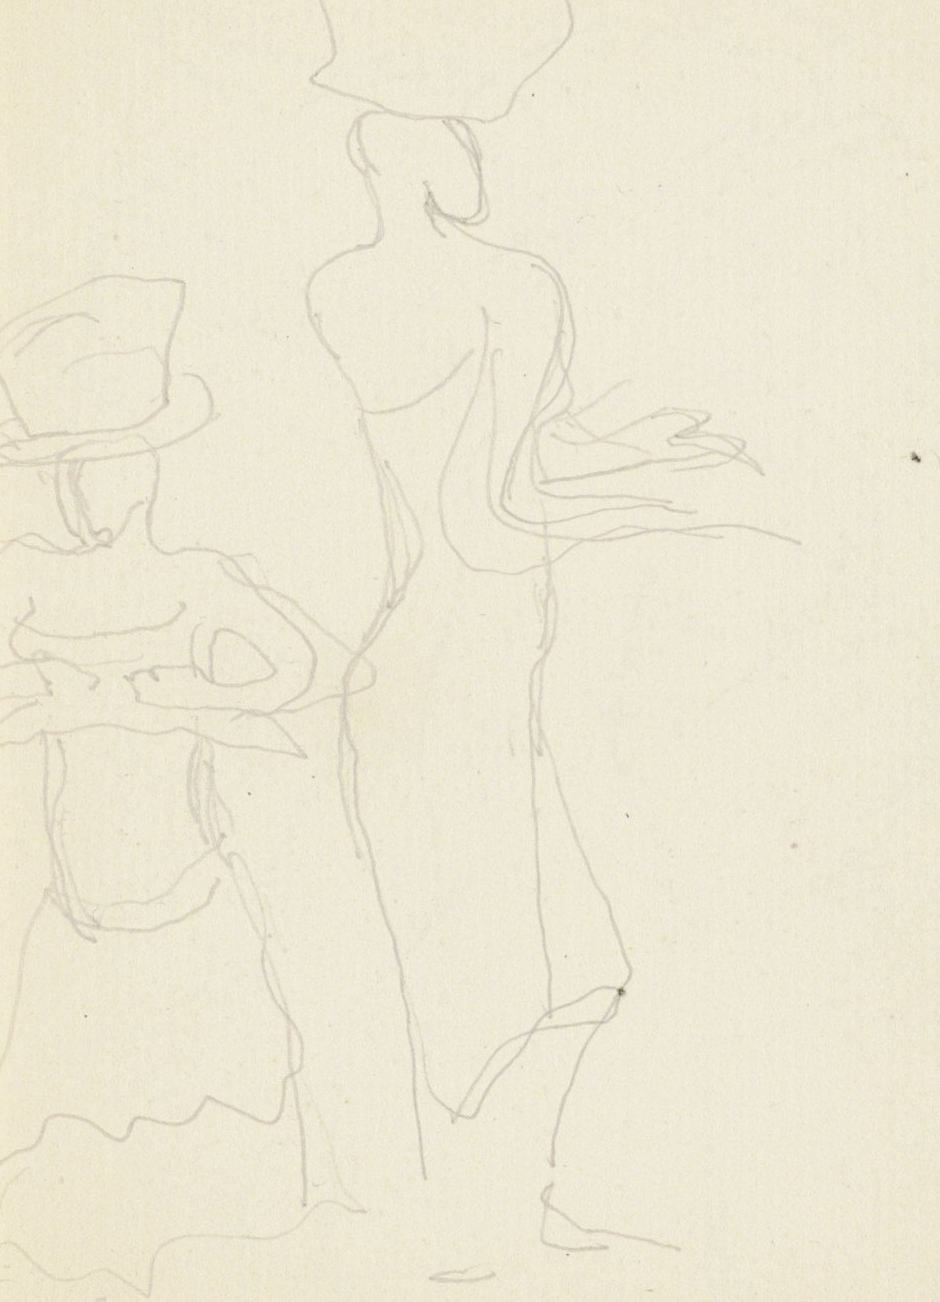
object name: sketchbook leaf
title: Twee Afrikaanse vrouwen die lasten op het hoofd dragen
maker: reijer stolk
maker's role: draughtsman, print maker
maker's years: 1896-1945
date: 1916-1945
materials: paper, pencil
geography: africa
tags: africans, carrying something on the head or on the shoulders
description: Blad 18 recto uit een schetsboek met 60 bladen.